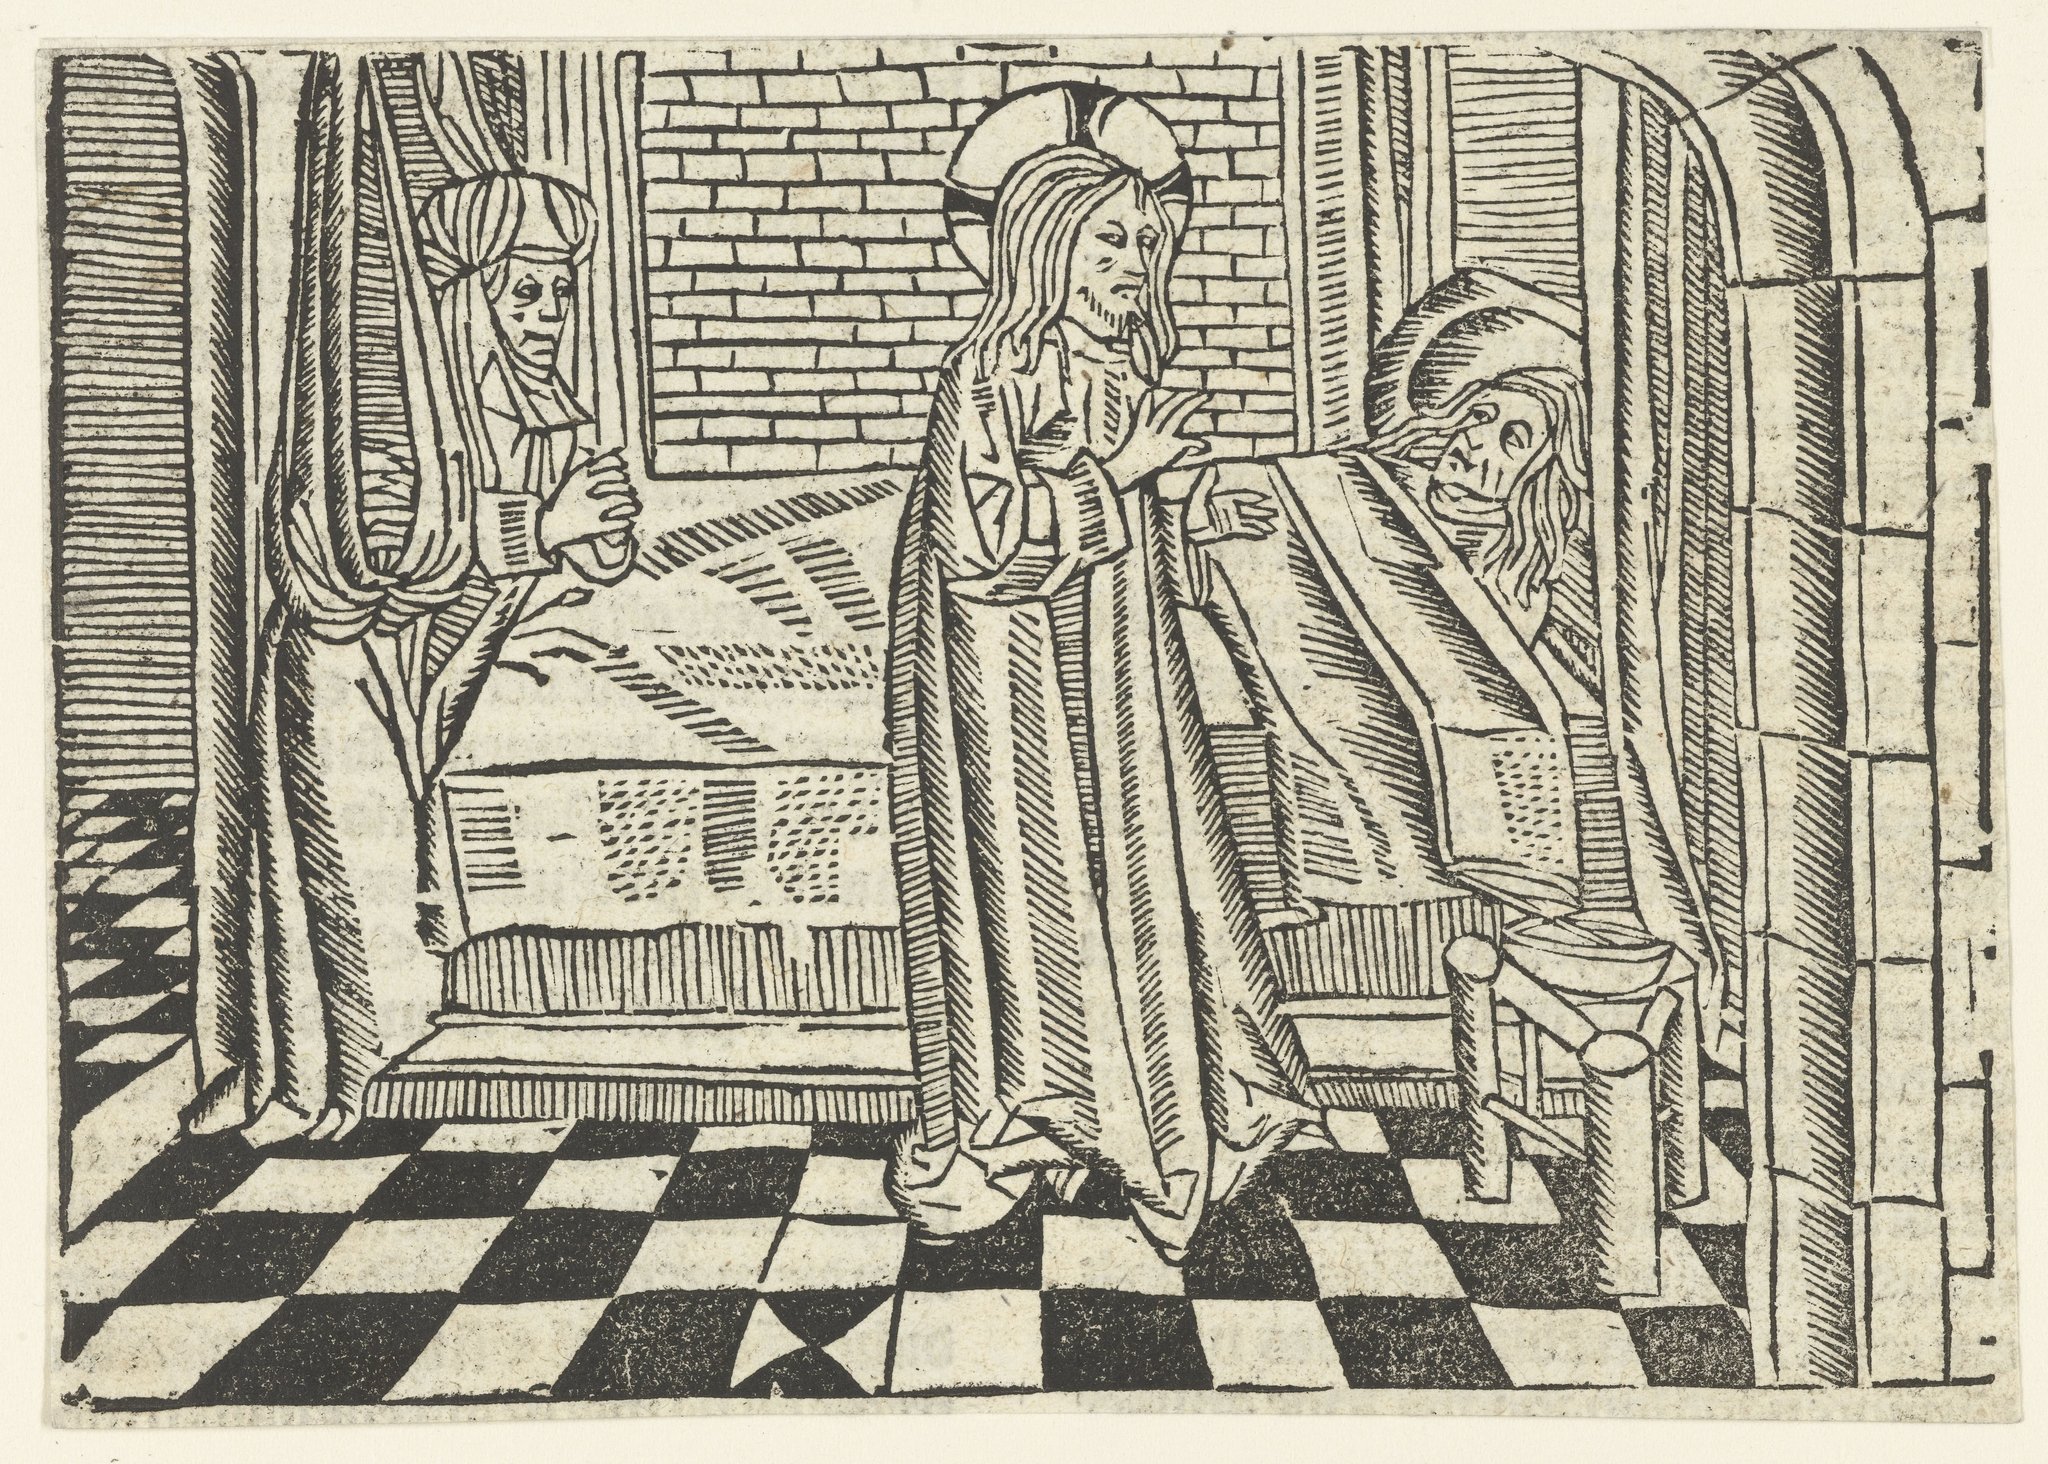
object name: book illustration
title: Christus wekt de dochter van Jaïrus op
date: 1480-1500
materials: paper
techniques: woodcut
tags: raising of the daughter of jairus, who is lying in bed (matthew 9:18-19, 9:23-26; mark 5:21-24, 5:35-43; luke 8:40-42, 8:49-56)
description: Eén blad van 113 uit Ludolphus de Saxonia, "Dit es dleué ons liefs heeren ihesu christi". Anonieme Nederlandse vertaling. Uitgegeven door Henrick Eckert van Homberch te Antwerpen in 1503. Botke, K. Deze 113 houtsneden, die meestal reeds in vroege Nederlandse boeken gebruikt zijn, worden toegeschreven aan de tweede Meester van Delft, de Meester van de Delbecq-Schreiber-passie en de Meester van de Virgo inter Virgines. In Conway (1884) en in "De gulden passer"(1951) zijn ook eerdere versies opgenomen. Botke, K.